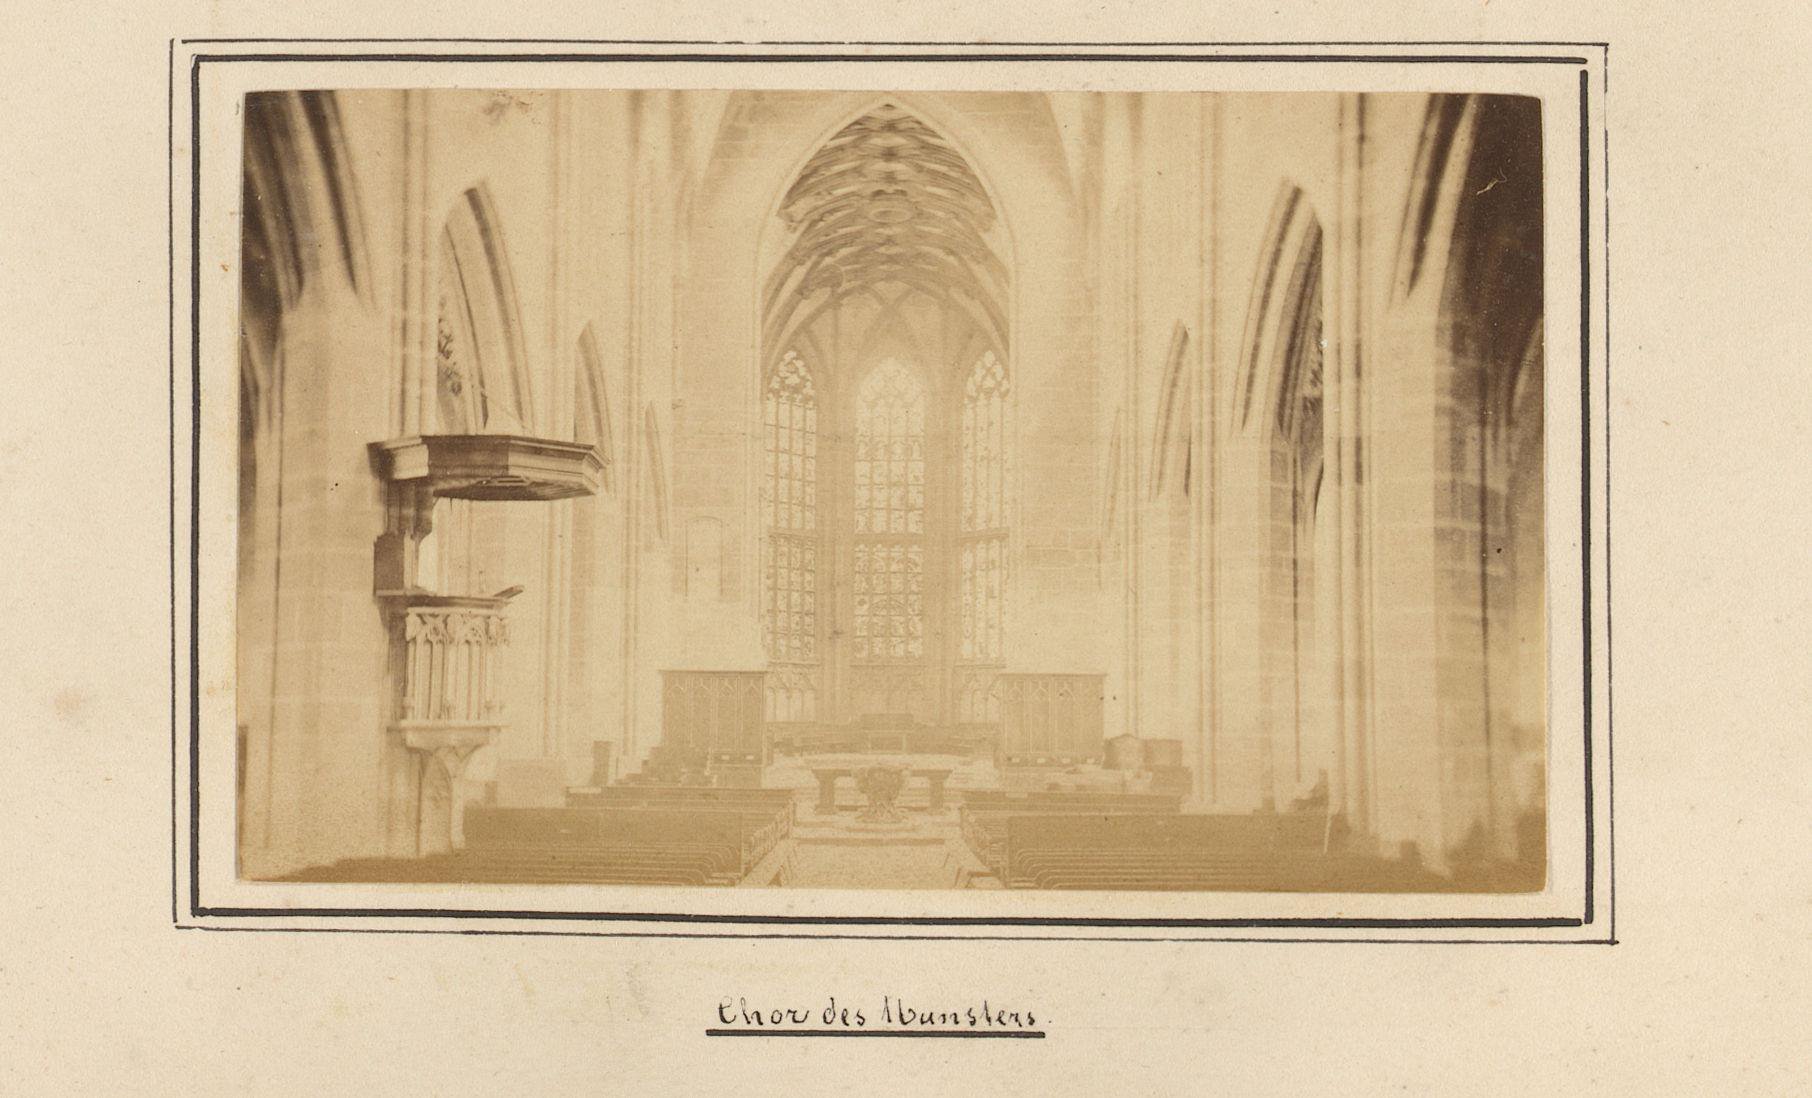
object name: album leaf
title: Koor van de Münsterkerk te Bern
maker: Anonymous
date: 1870-1890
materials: paper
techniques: albumen print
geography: bern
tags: parts of church interior: choir, bern minster